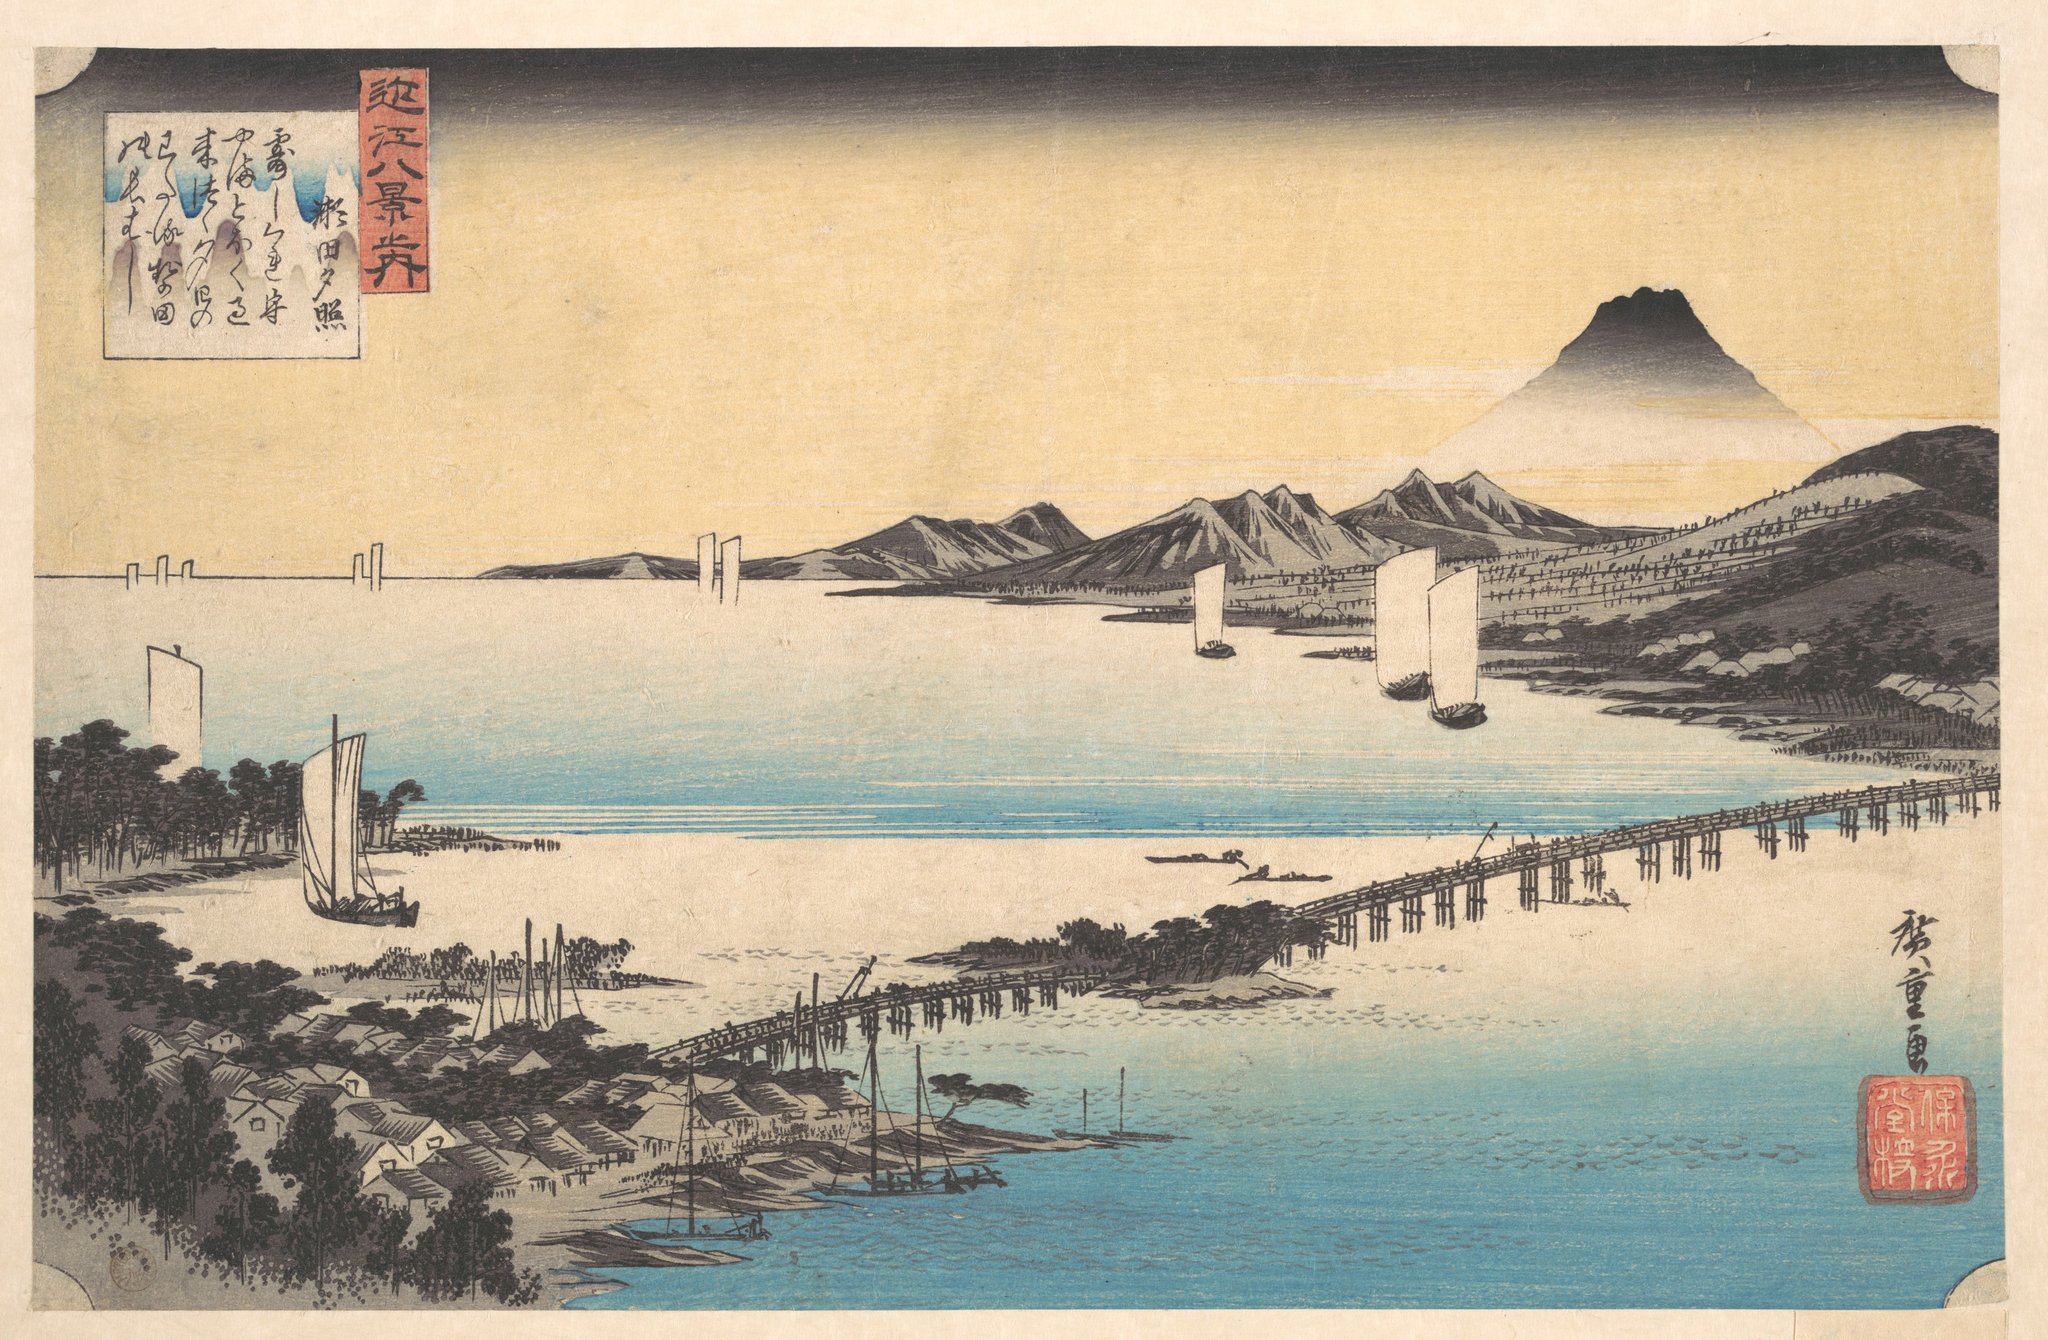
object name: print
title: Seta no Sekisho. Sunset, Seta. Lake Biwa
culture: japanese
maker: utagawa hiroshige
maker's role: artist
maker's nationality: japanese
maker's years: 1797-1858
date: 1835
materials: ink, paper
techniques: woodblock print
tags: bridges,lakes,mountains,landscapes,boats